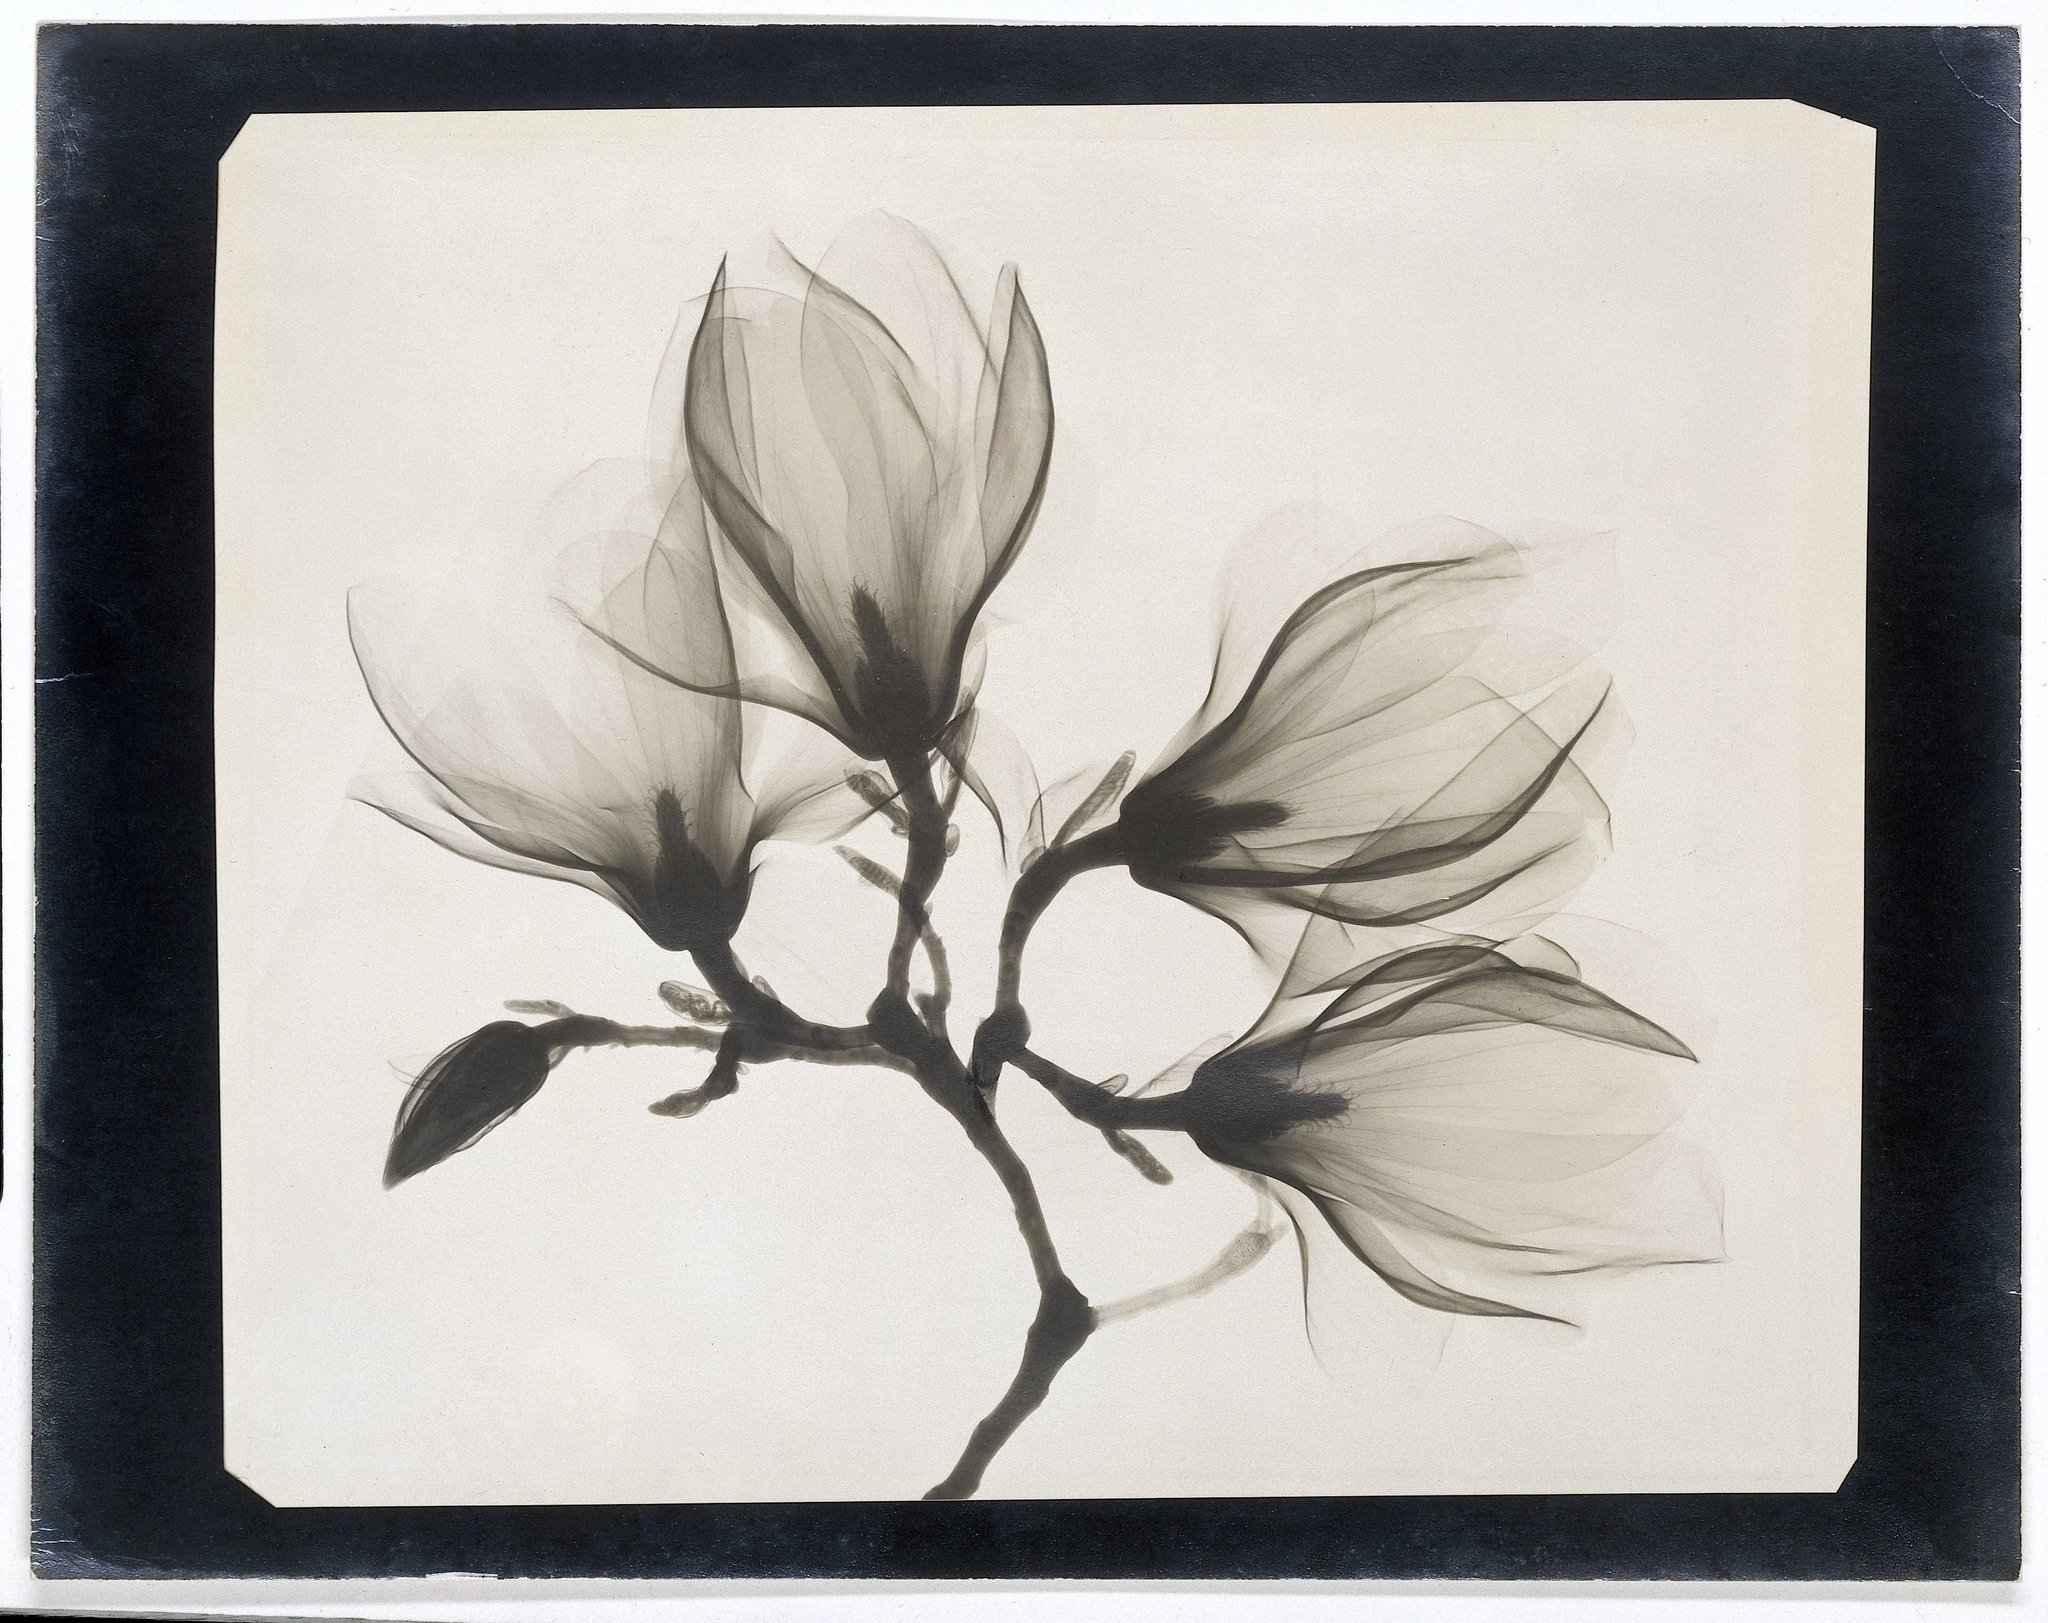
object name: x ray photograph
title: Branch of flowering magnolia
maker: Anonymous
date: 1910-1925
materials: paper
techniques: gelatin silver print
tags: flowers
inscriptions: inscription: ‘B’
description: A few years ago, this photograph was a best-seller in the Rijksmuseum shop: a favourite for mourning cards. The image of the blooming magnolia branch originated in America. Several photographers active there at the beginning of the 20th century concentrated on recording plants and flowers. The maker of this X-ray photograph was undoubtedly captivated by the petals’ delicate transparency.